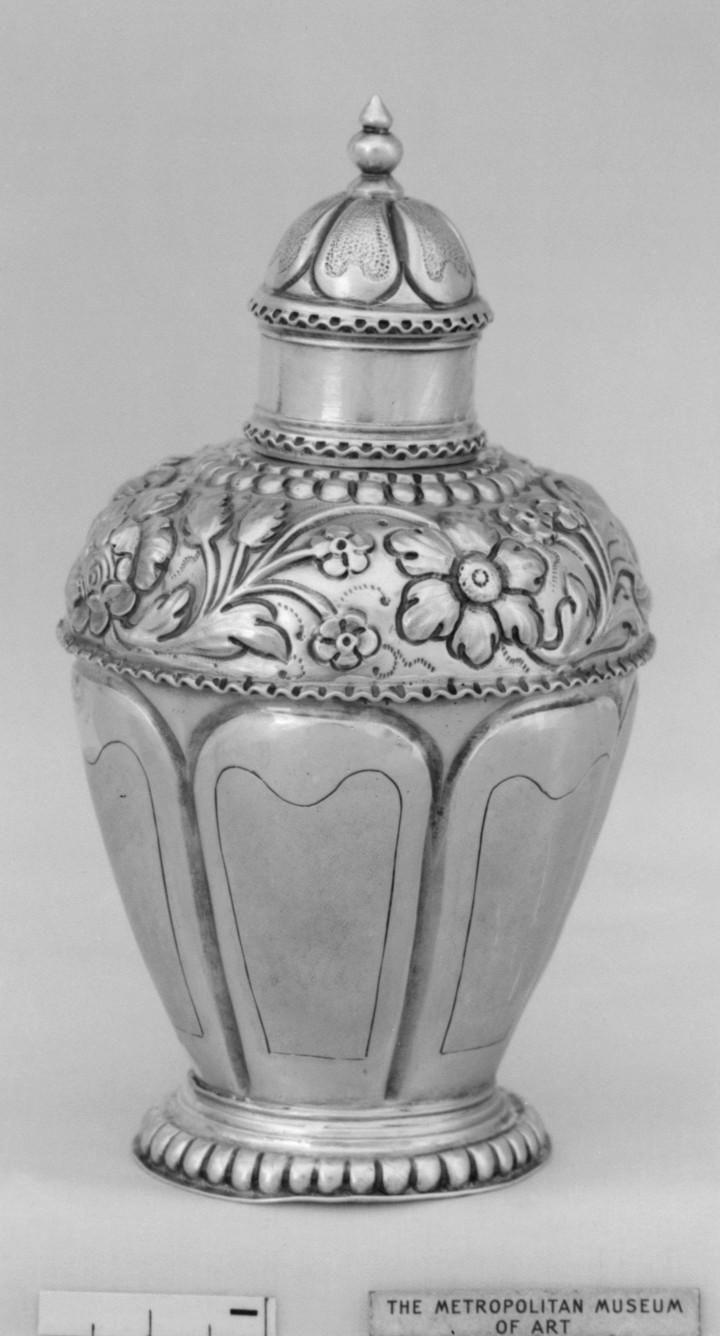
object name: tea caddy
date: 1701-1800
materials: silver